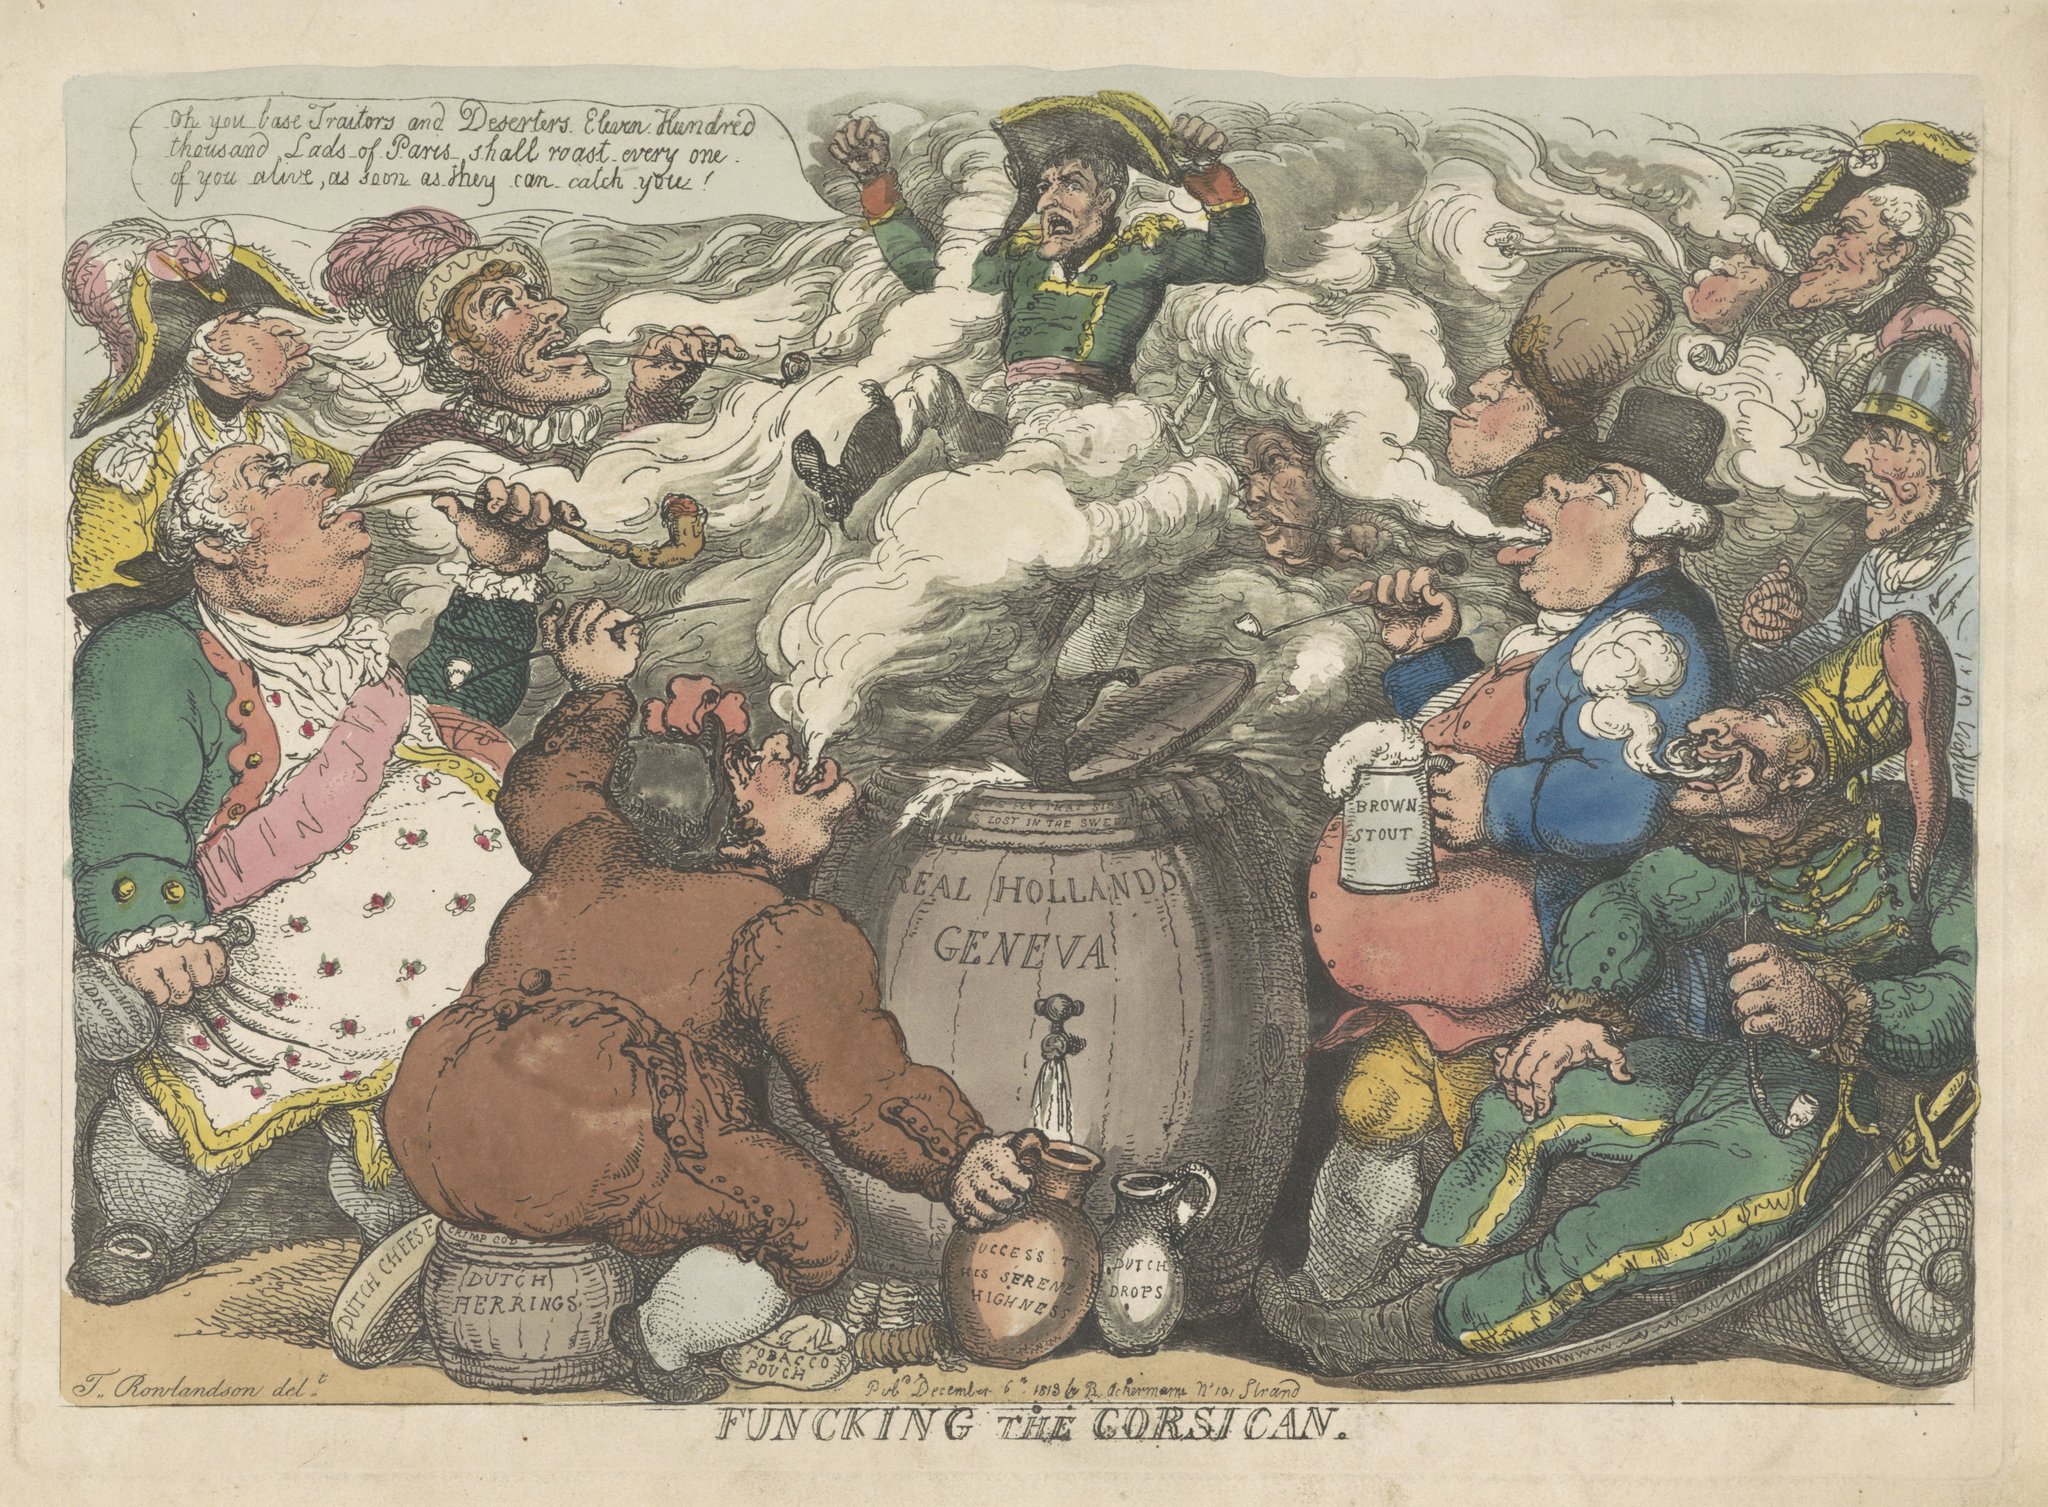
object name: cartoon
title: Funcking the Corsican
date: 1813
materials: paper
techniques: aquatint, etching, hand coloring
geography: london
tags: napoleon i (emperor of the french), smoke, personifications of countries, nations, states, districts, etc., pipe ~ tobacco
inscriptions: collector's mark: Lugt 2228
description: Spotprent op Napoleon na zijn verlies in de slag bij Leipzig, 1813. Een kleine figuur van Napoleon staat boos te stampvoeten bovenop een grote houten vat met Hollandse jenever waardoor de deksel los raakt. Vertegenwoordigers van verschillende Europese landen roken allen pijp en blazen tabaksrook naar de keizer. Vooraan een dikke Hollander gezeten op een tonnetje haring en een kaas, Rechts de Engelse John Bull, een Pruisische huzaar en anderen. Links de koning van Württemberg, een Oostenrijker en een Spanjaard.